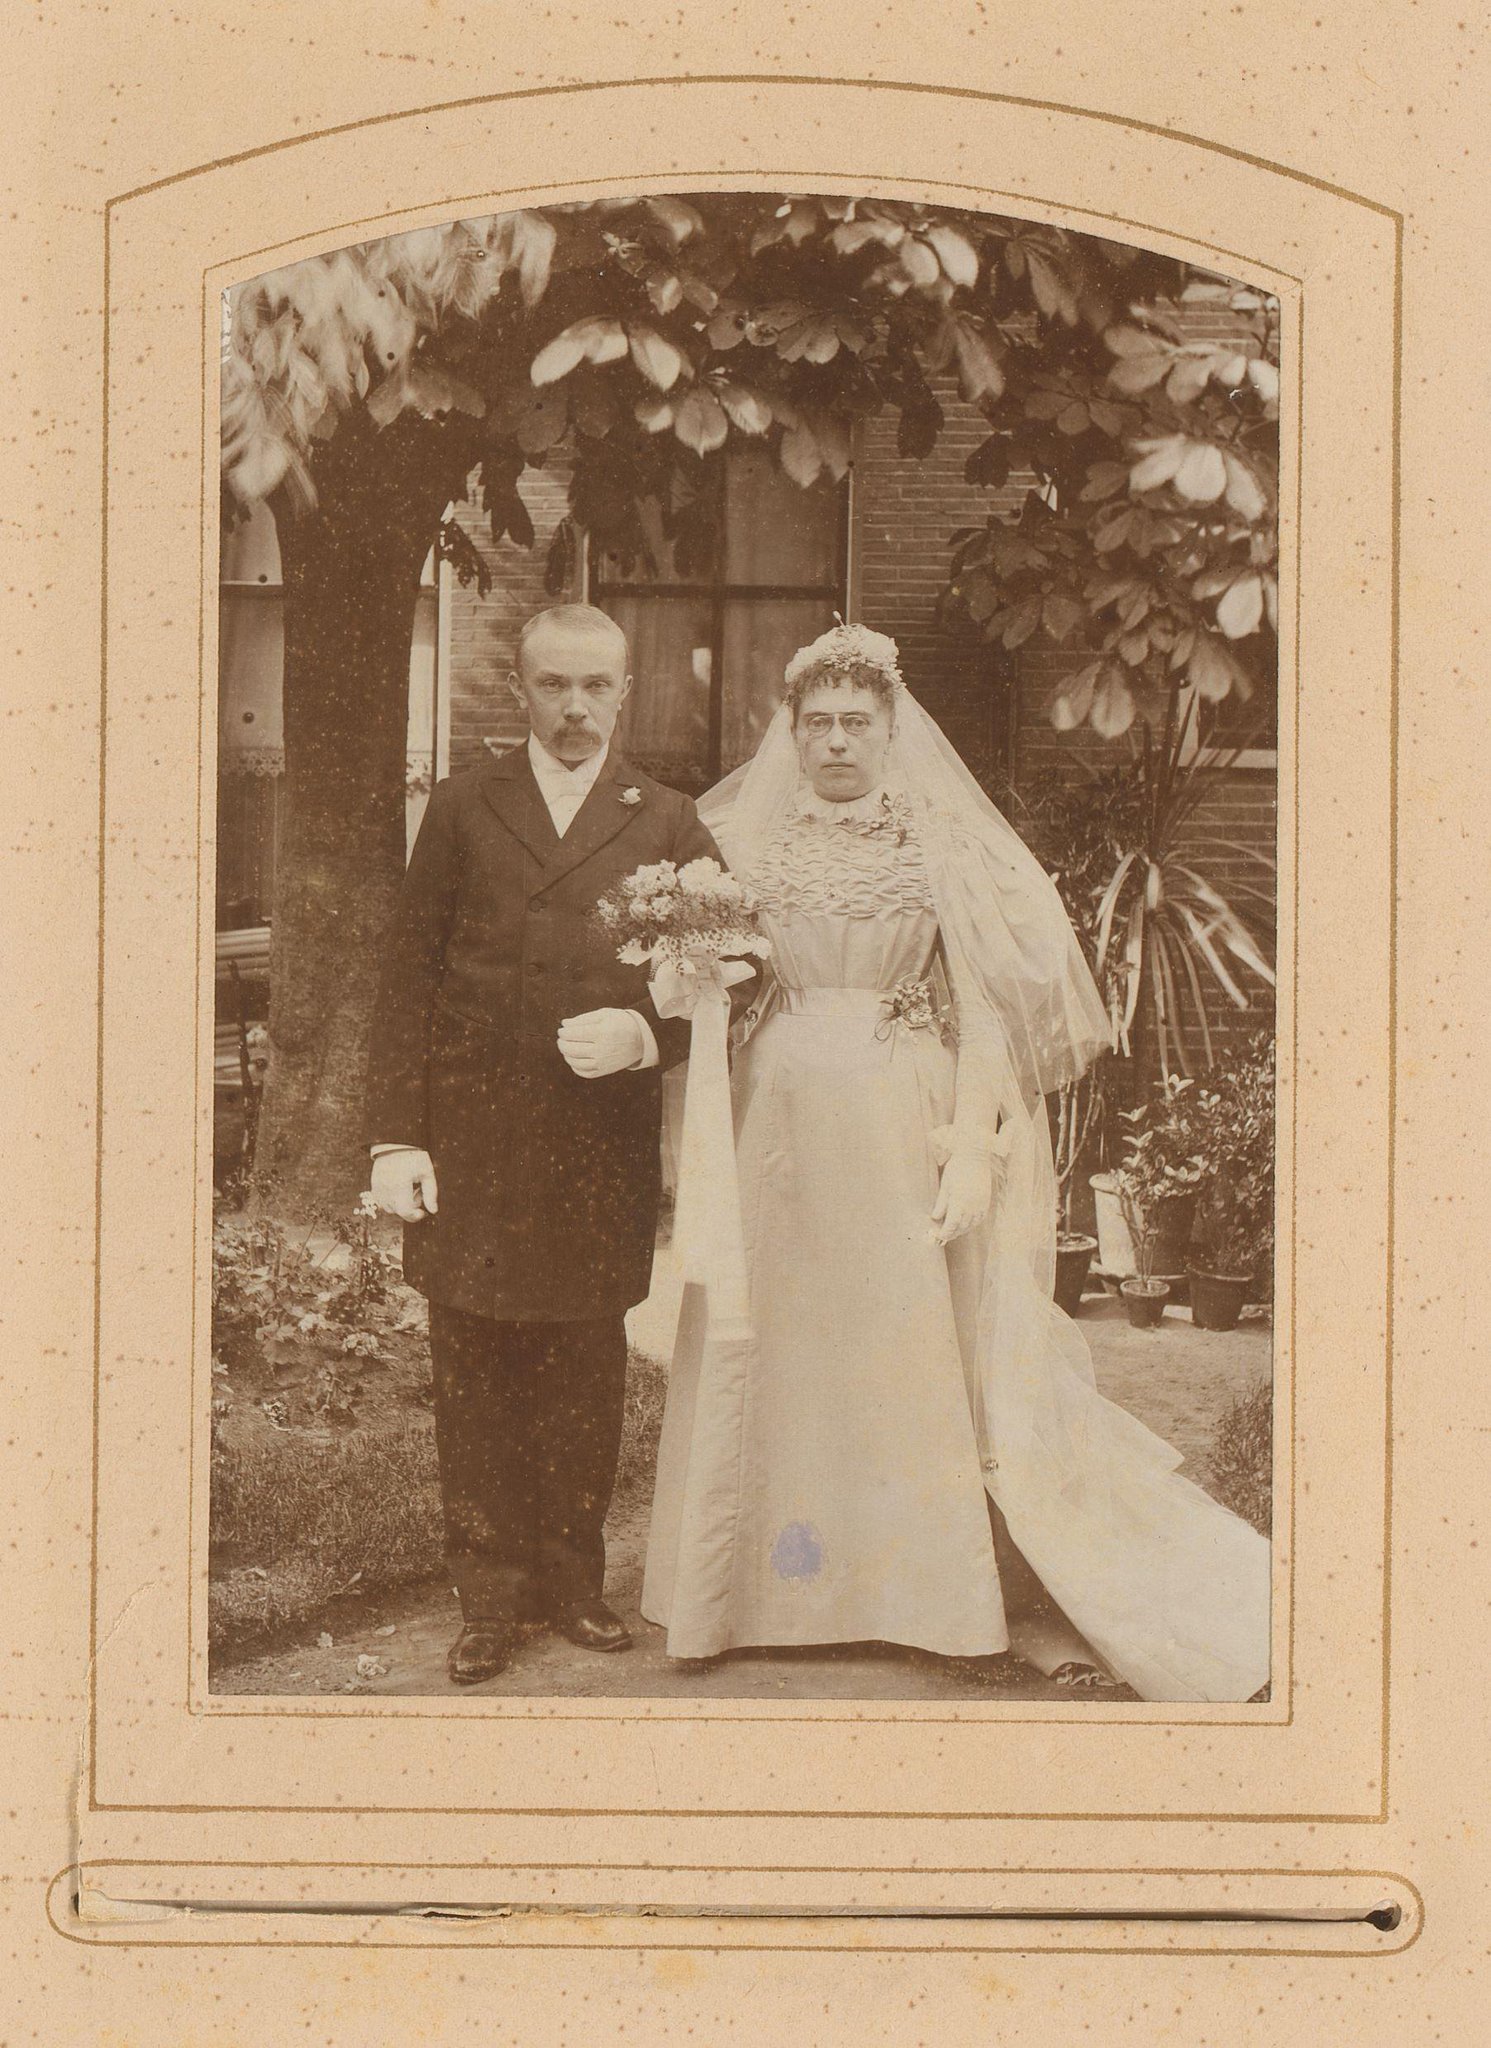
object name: album leaf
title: Portret van een bruidspaar in de tuin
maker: johannis lasonder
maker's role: fotograaf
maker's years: 1863-1917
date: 1890-1917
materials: cardboard, photographic support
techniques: collodion silver print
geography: schoonhoven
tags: bride and groom in wedding-dress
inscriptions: inscription: ‘J. Lasonder/ Schoonhoven’